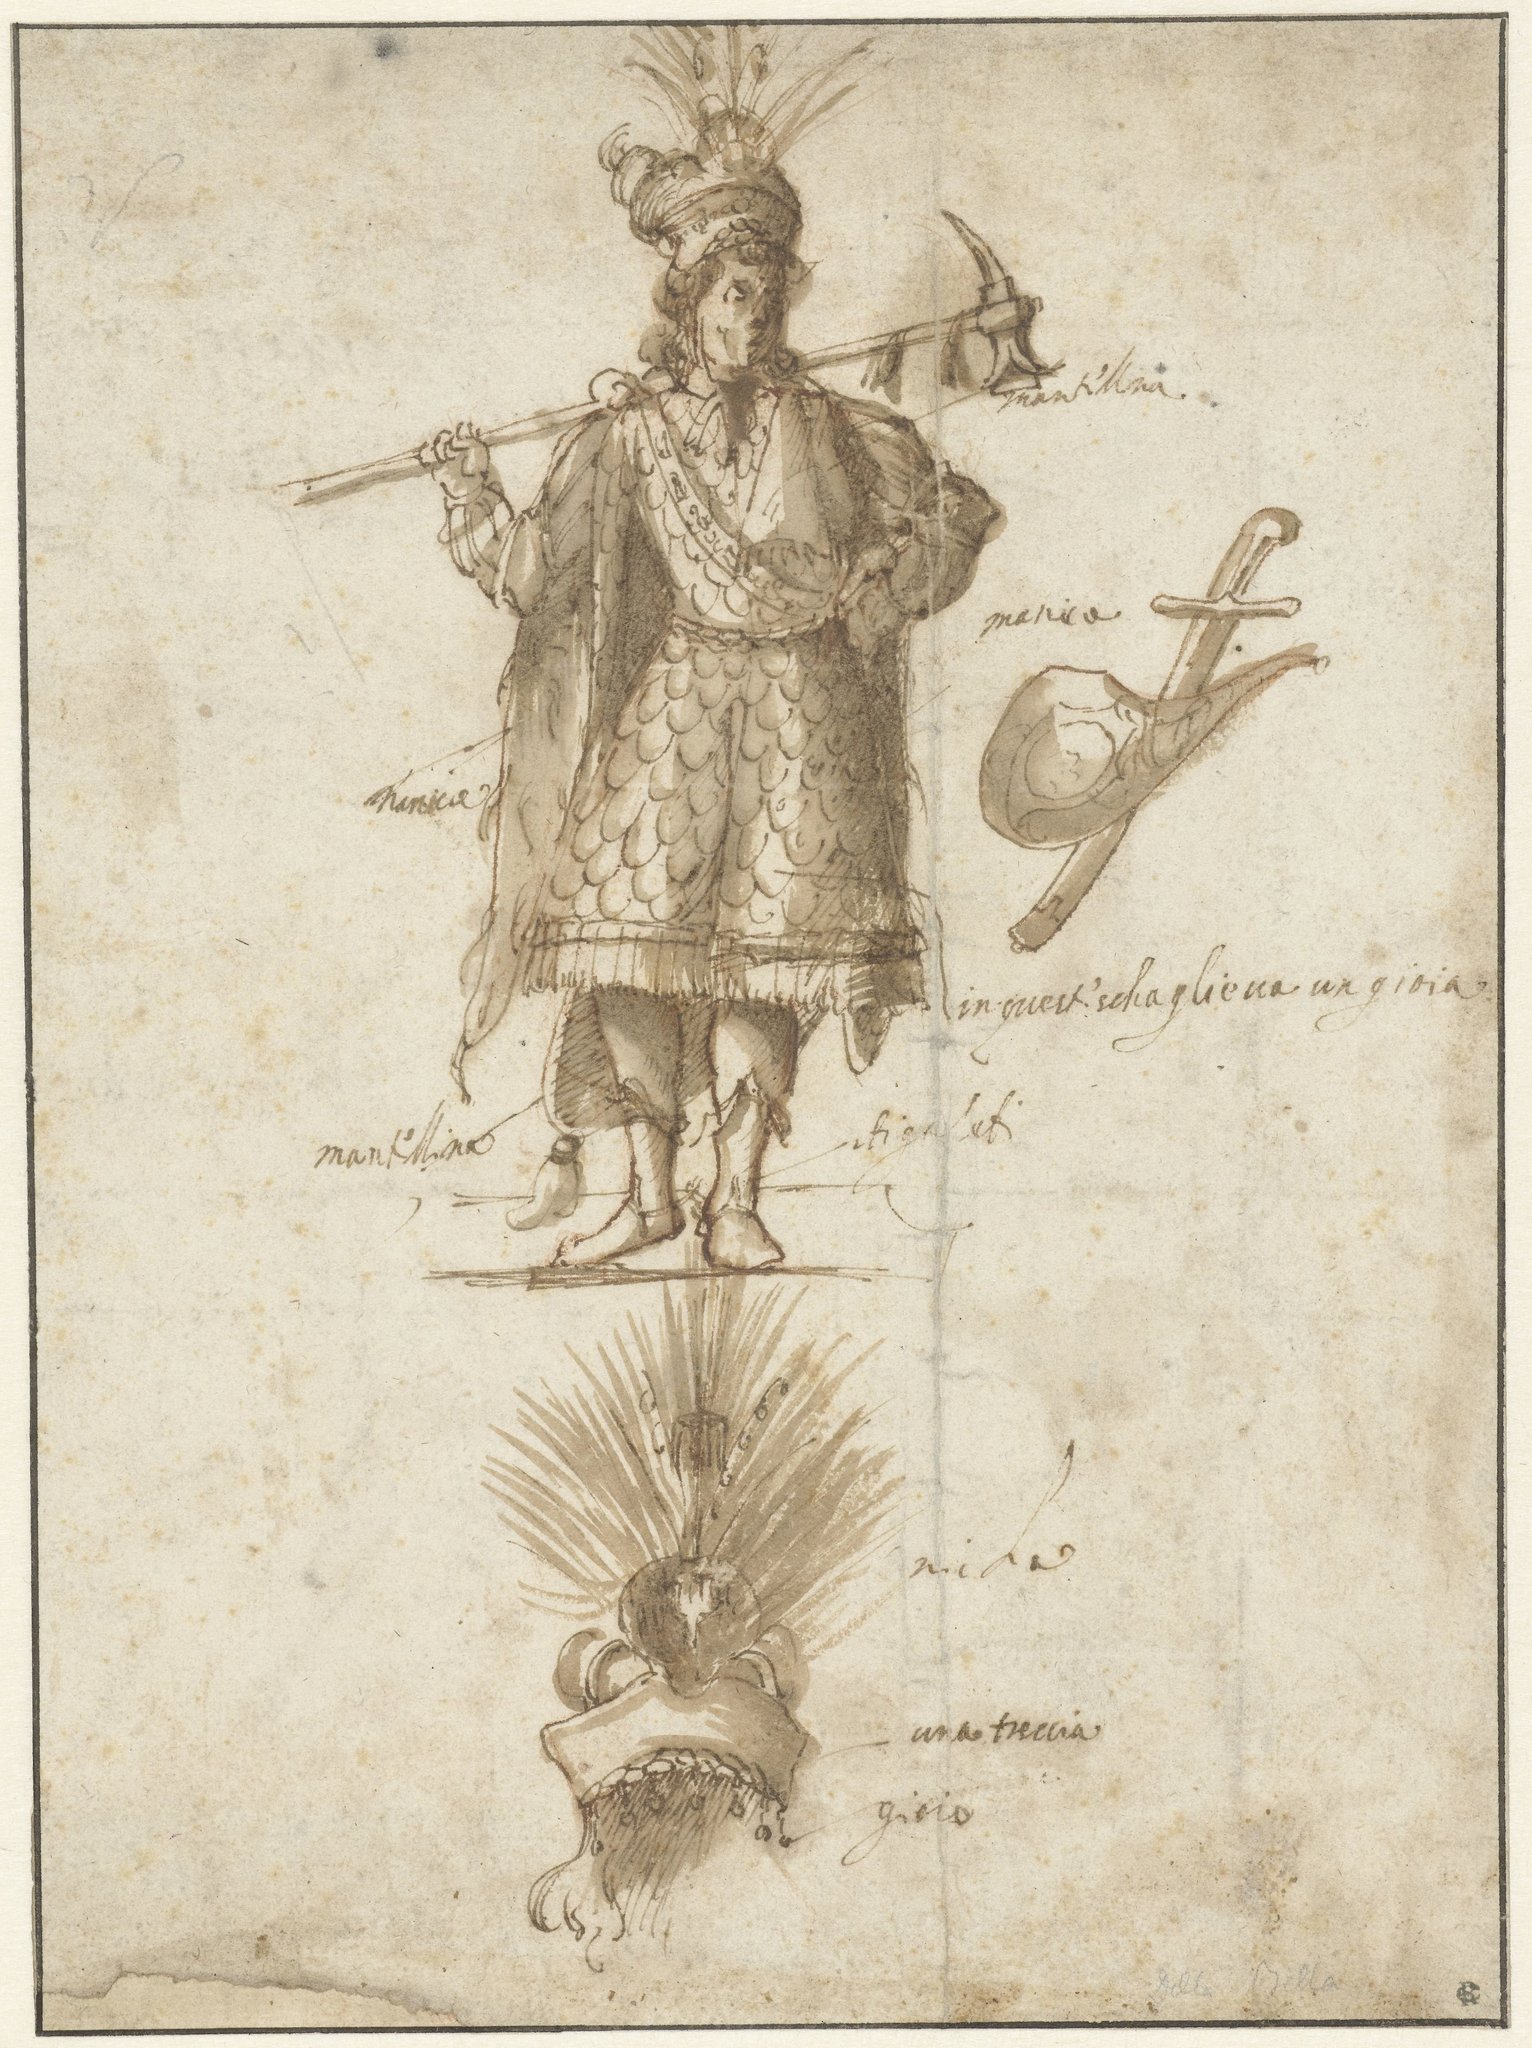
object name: drawing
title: Studies van een maskerade: een krijgsman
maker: Anonymous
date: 1557-1640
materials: ink, paper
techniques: brush, pen